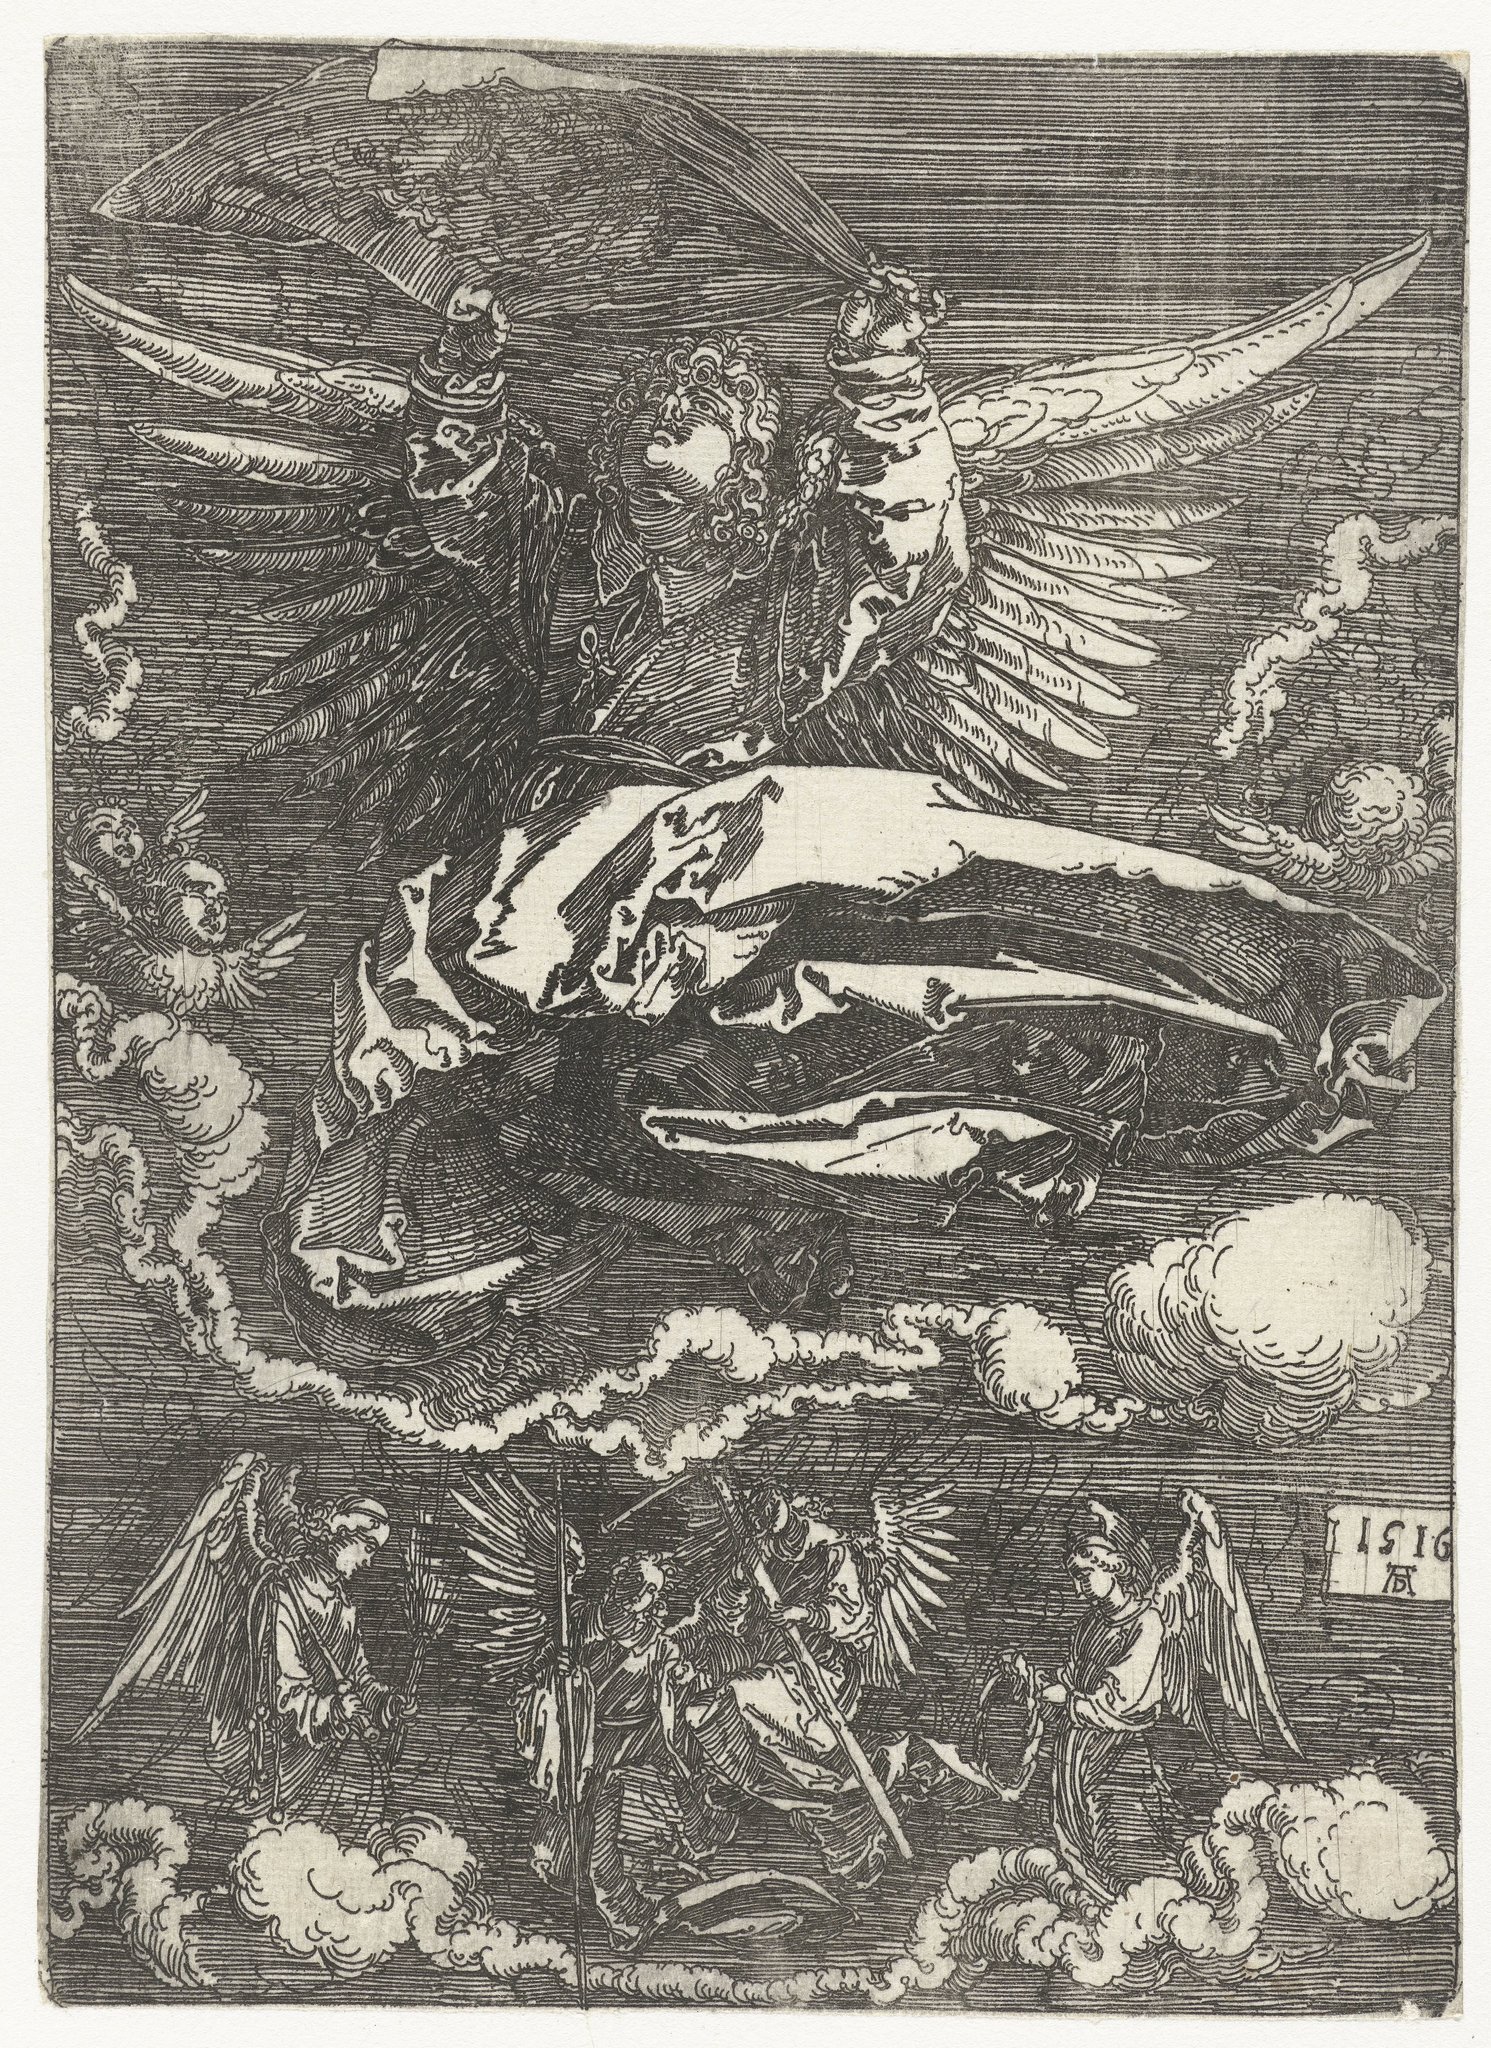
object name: print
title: Engelen met de zweetdoek en de passiewerktuigen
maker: albrecht dürer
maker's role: draughtsman, painter, print maker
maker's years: 1471-1528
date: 1516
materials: paper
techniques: etching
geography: nuremberg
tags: 'arma christi', 'vera icon', held up by angels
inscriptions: collector's mark: Lugt 240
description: Zwevend tussen de wolken houdt een engel de zweetdoek met de afdruk van het gelaat van Christus vast (het sudarium). Onder hem houdt een aantal engelen de passiewerktuigen vast.